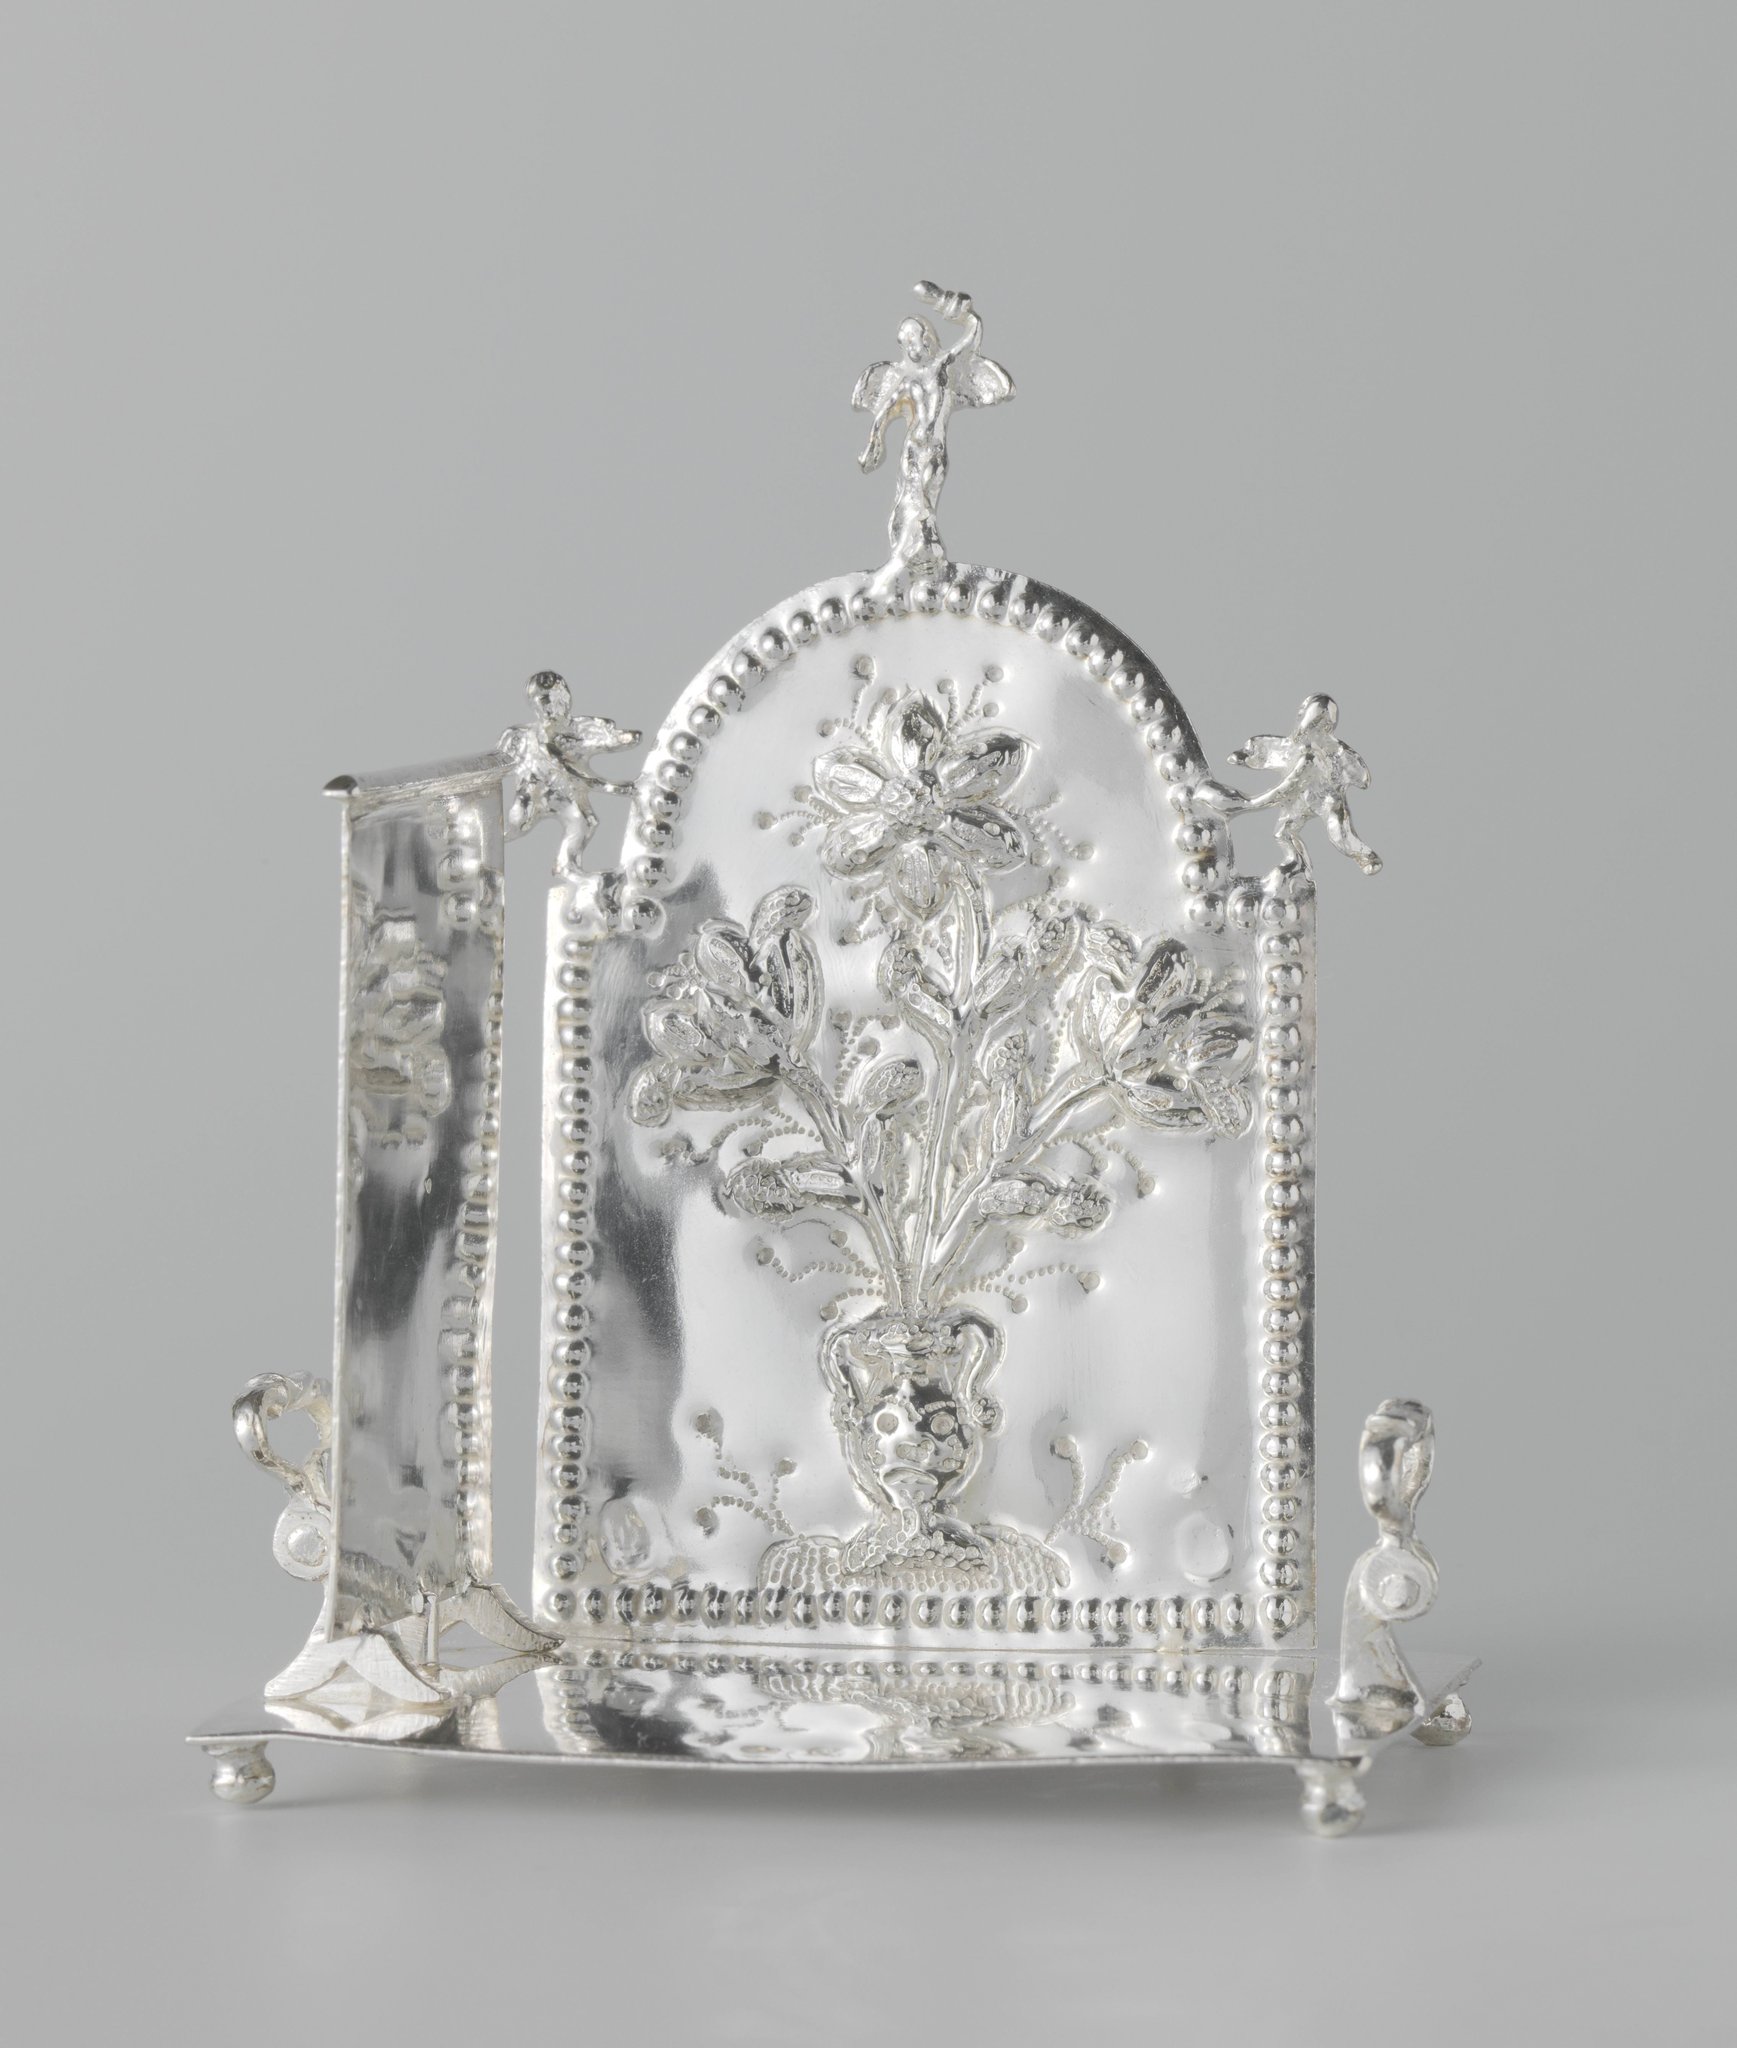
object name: miniature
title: Haardplaat en vuurscherm op vuurplaat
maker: abraham van der hoeff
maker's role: silversmith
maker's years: 1686-1735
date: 1704-1734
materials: silver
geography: haarlem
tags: fire-screen, hearth-plate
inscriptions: maker's mark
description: Rechthoekige liggende haardplaat op vier bolpoten en aan weerszijden een handvat. Op een lange zijde staat een staande haardplaat met een ronde bovenkant. Het scherm is versierd met een gedreven vaas met bloemen. Op het scherm staan drie putti. Op een korte zijde staat een rechthoekig, onversierd haardscherm. Elk deel is gemerkt: stk.= Haarlem, mt.= Voet 88. In de staande haardplaat staat bovendien een dolfijn, in de liggende plaat een bijl en een onleesbaar merk en in het haardscherm een onleesbaar merk.